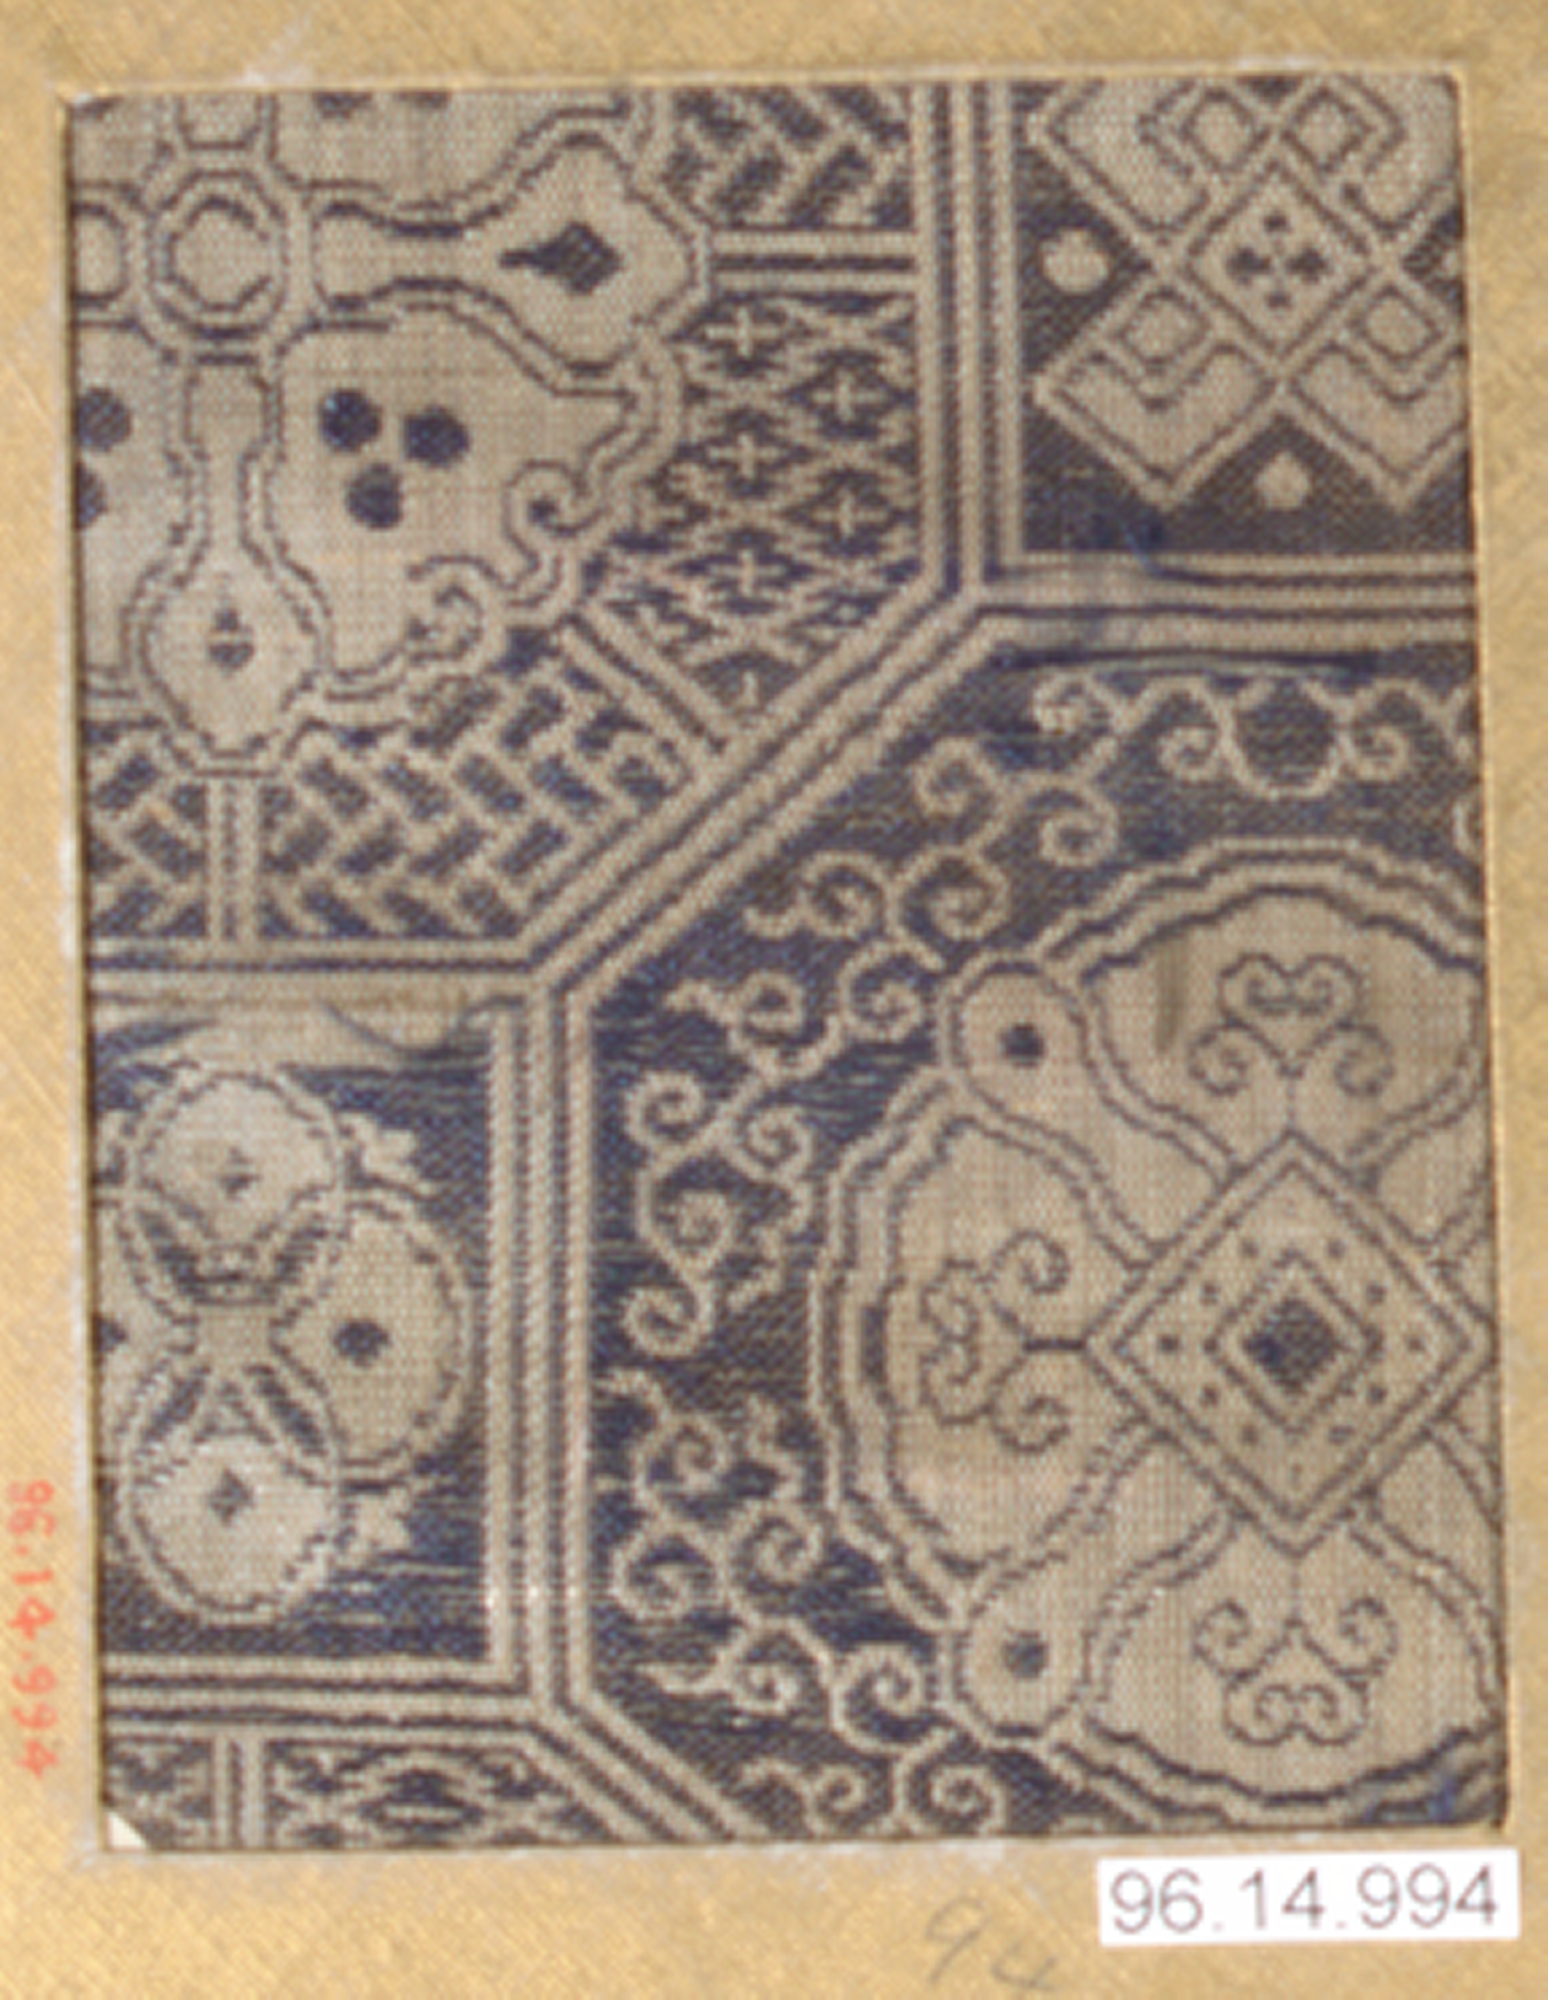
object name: piece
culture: japanese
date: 1701-1900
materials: silk